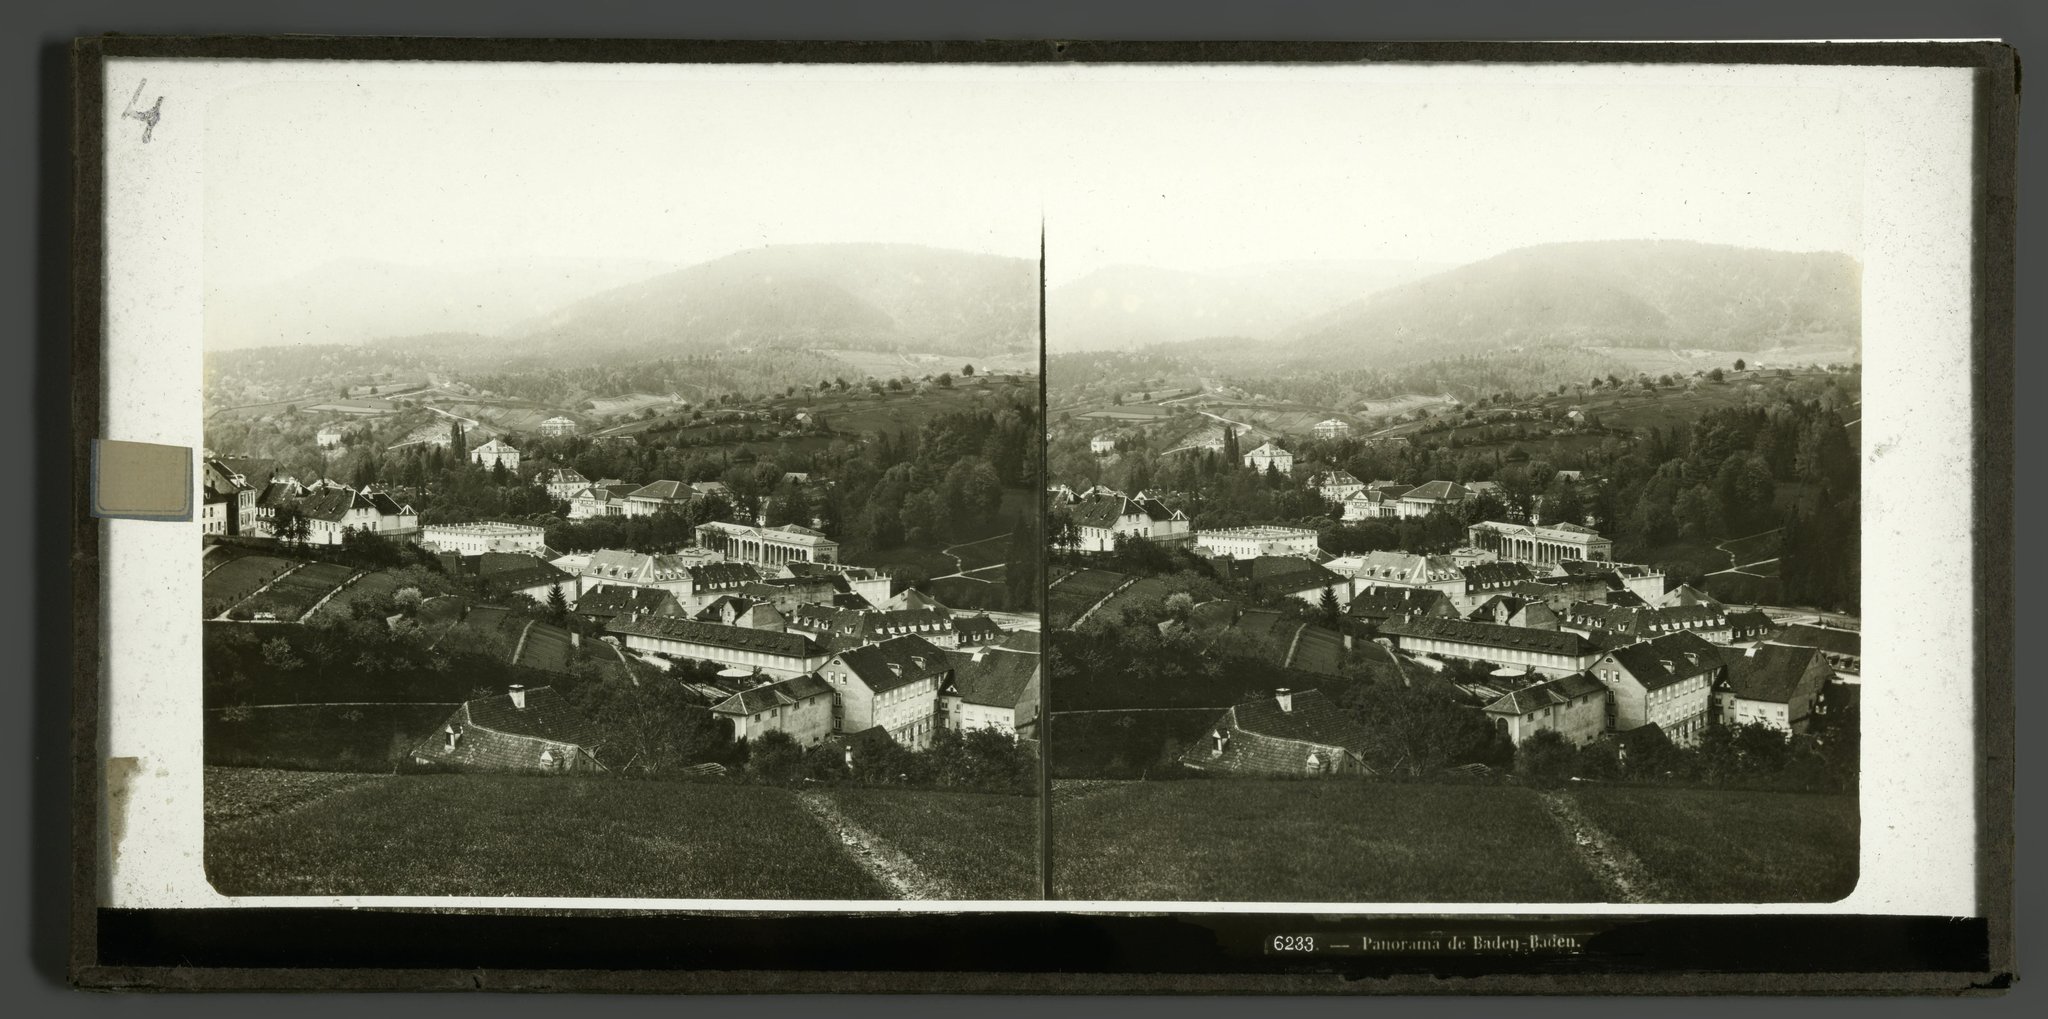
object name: stereoscopic photograph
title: Panorama de Baden-Baden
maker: ferrier père-fils et soulier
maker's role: publisher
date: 1860-1890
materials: glass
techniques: slide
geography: baden-baden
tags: city-view in general; 'veduta'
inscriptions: number: ‘4’, number: ‘6233.’